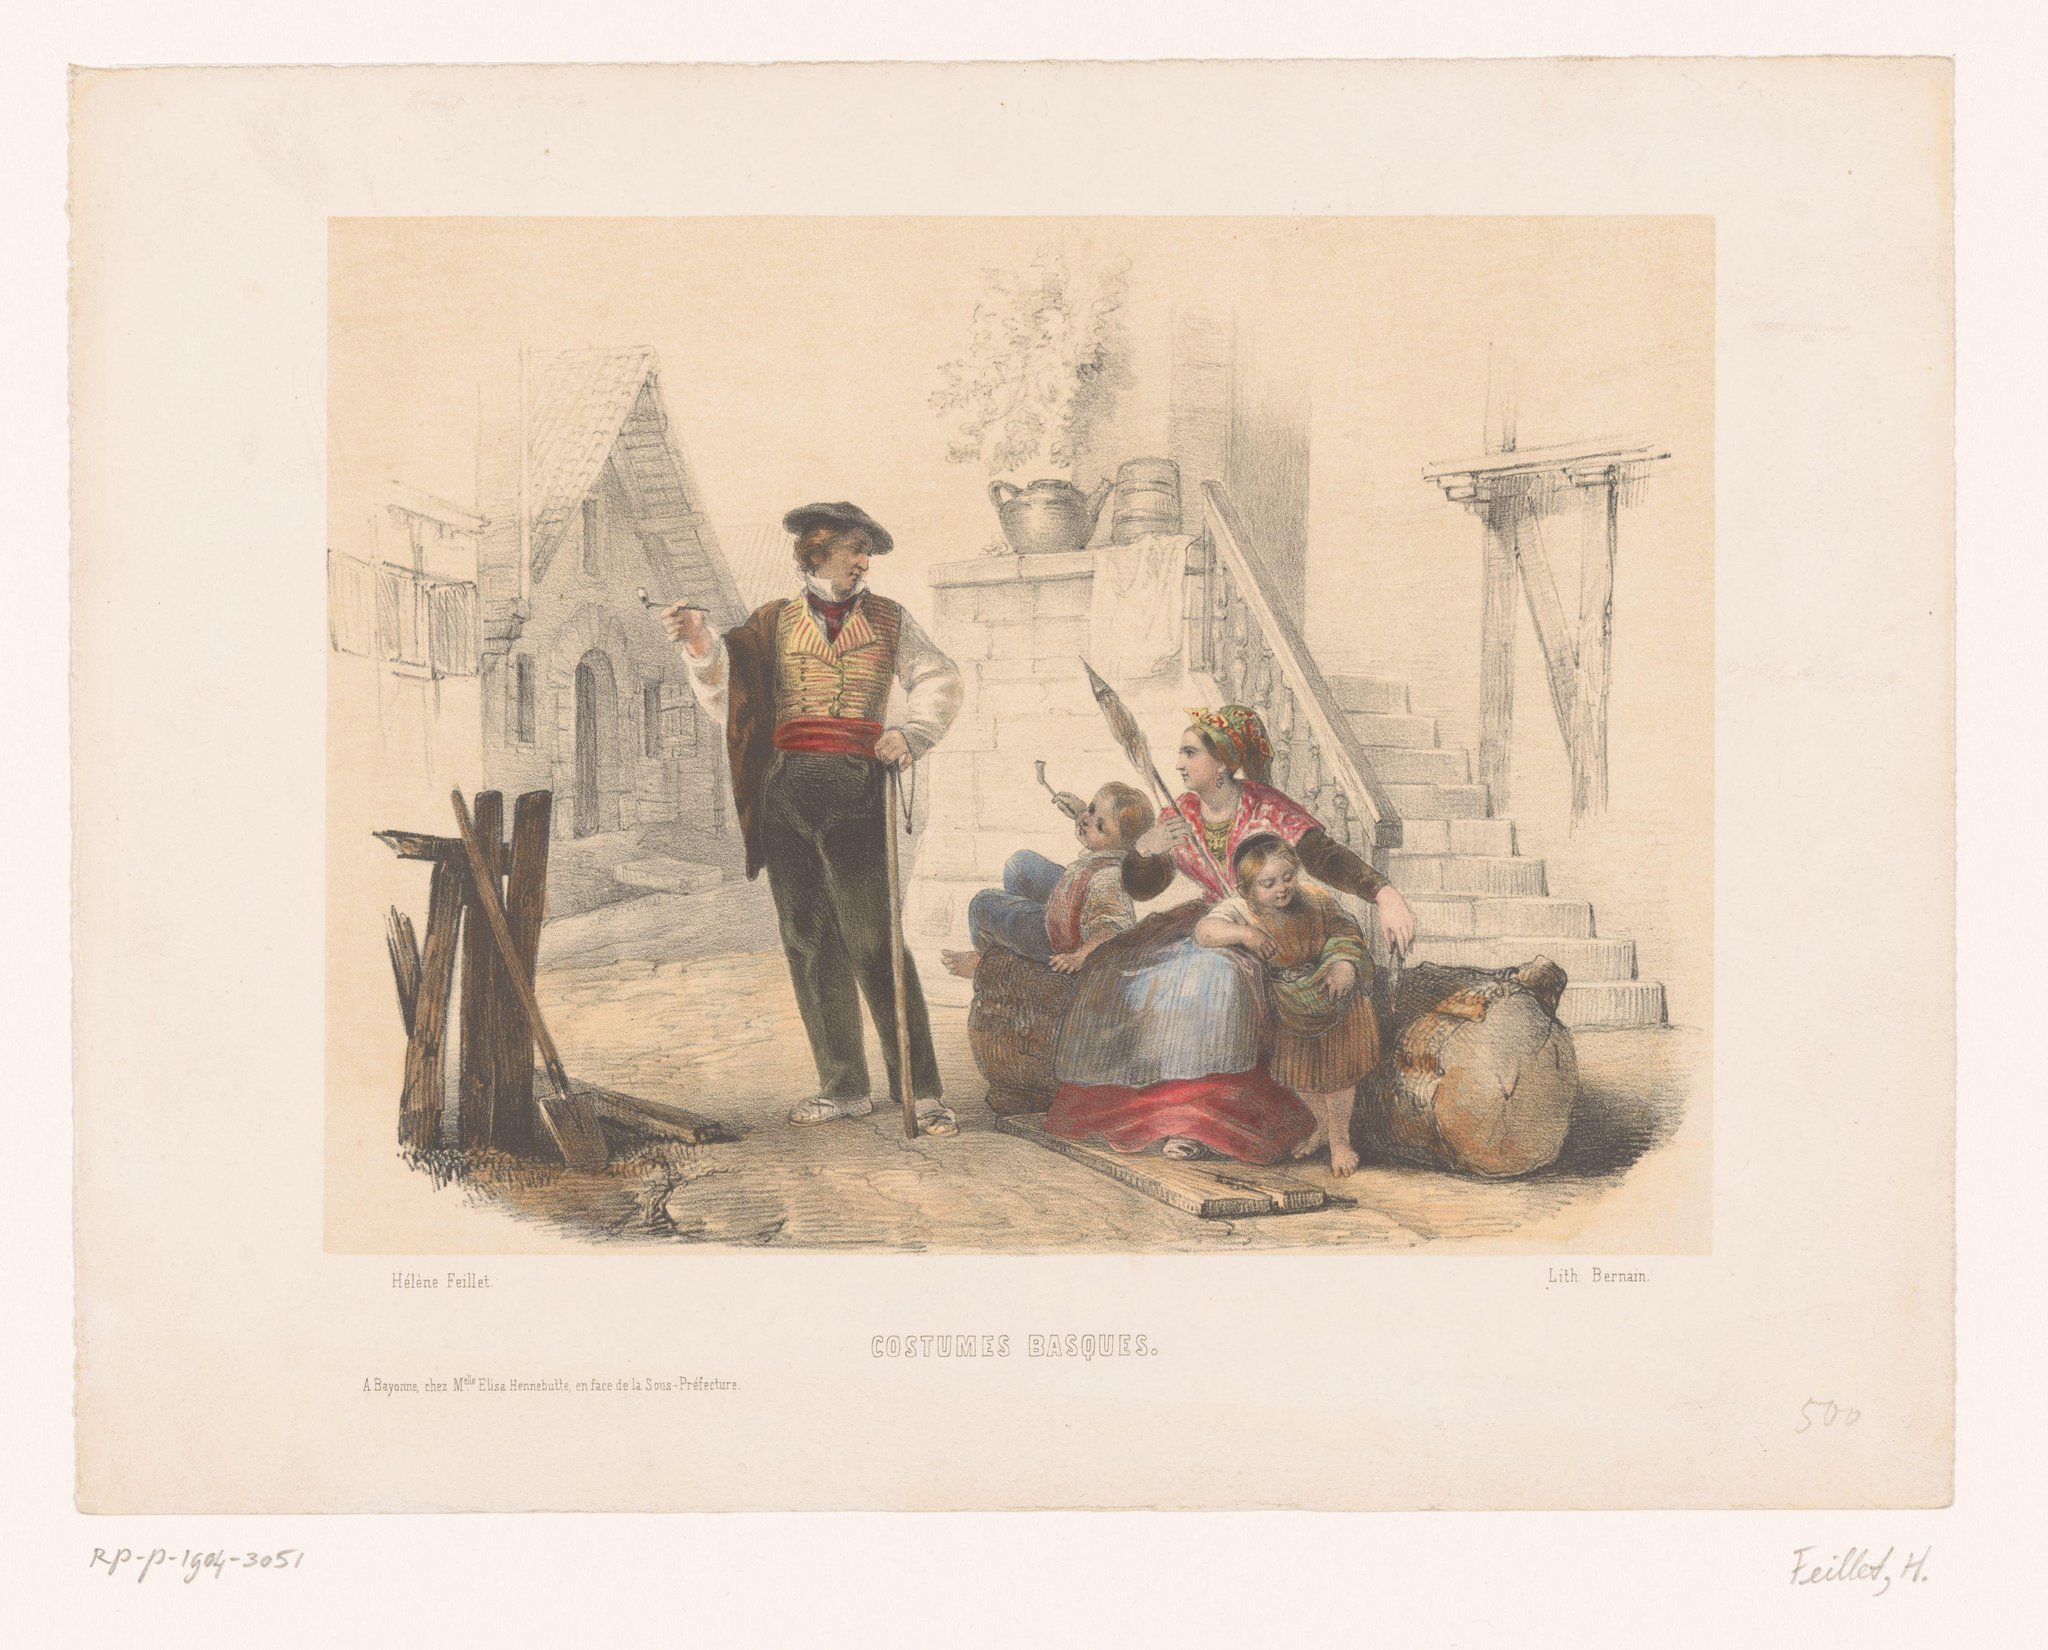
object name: print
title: Gezin in Baskische kostuums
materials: paper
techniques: hand coloring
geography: bayonne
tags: parents with their children, folk costume, regional costume, human races; peoples; nationalities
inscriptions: collector's mark: Lugt 2228a